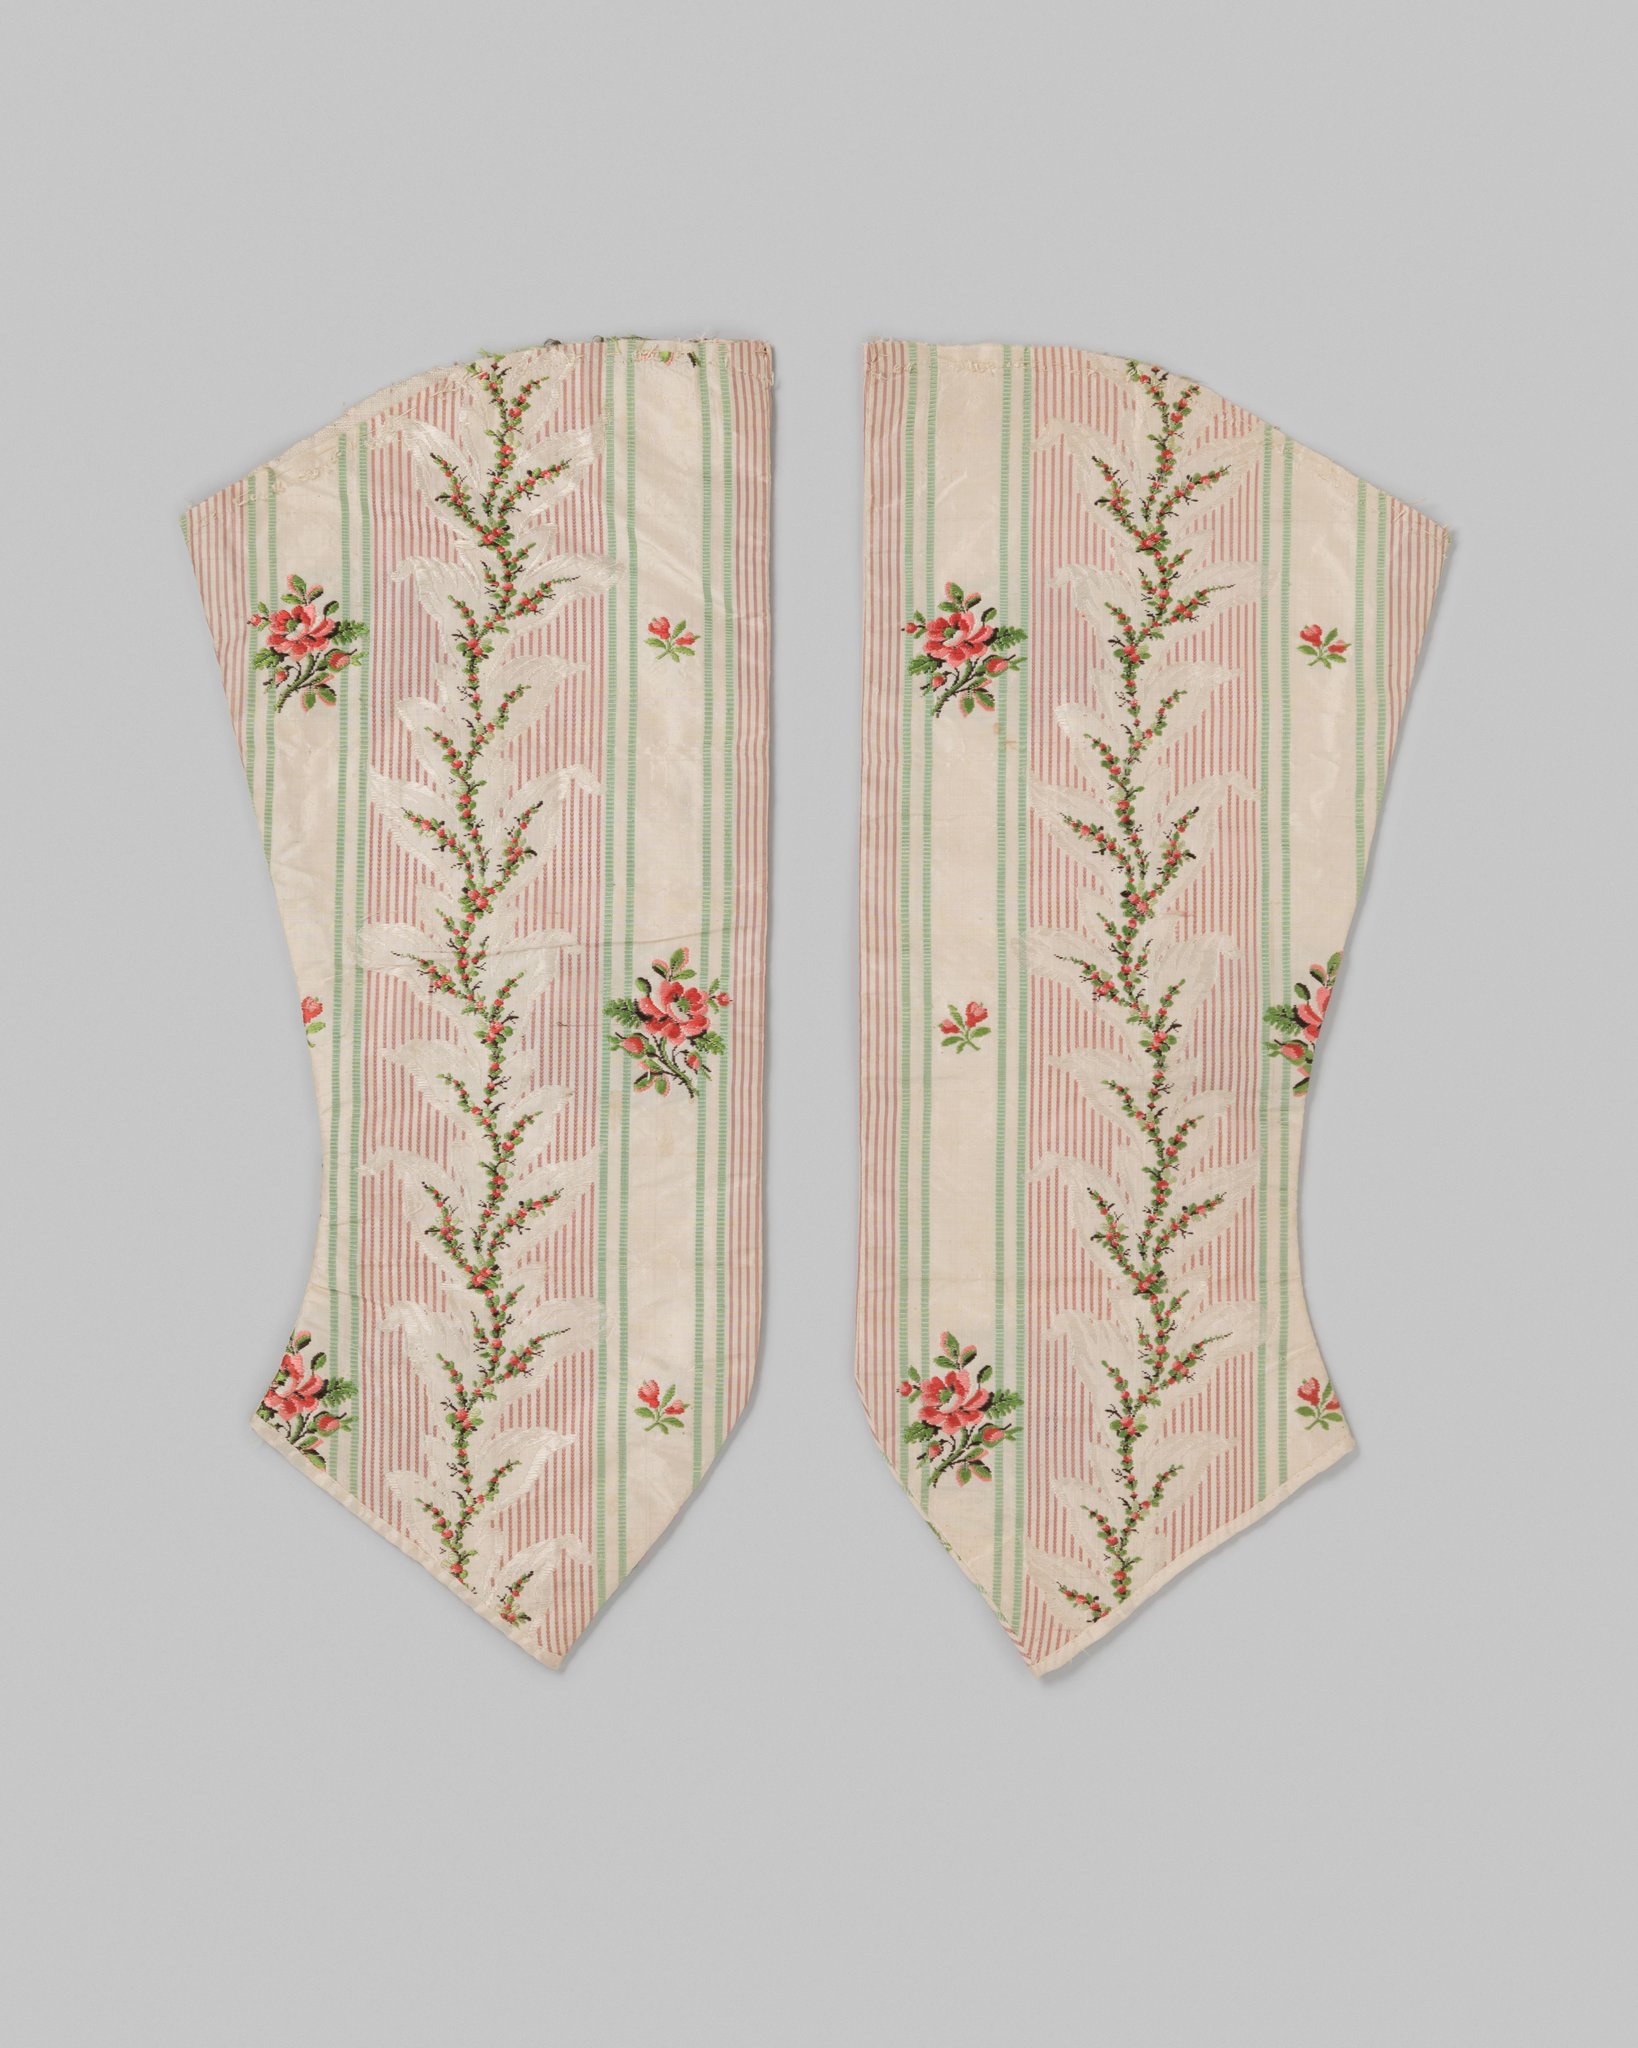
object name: sleeve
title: Mouw van zijde met streepmotief waarop floraal borduursel in verschillende kleuren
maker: Anonymous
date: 1780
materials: silk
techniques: embroidered, weave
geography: haarlem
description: Paar mouwen van een Louis XVI-japon. Model. Driekwart lang met aangeknipte elleboogvorm. Binnen- en buitenraad. Onderaan omboord met lintje.Weefsel. Streep effekten van dubbele groene lijstjes naast een witte baan, waarop losse strooiroosjes staan. Deze wisselen af met een brede baan van wit met fijne rose streepjes, waarover heen een bladrank loopt, in wit uitgespaard en daarop slingert weer een zeer fijn takje met roze bloesem.